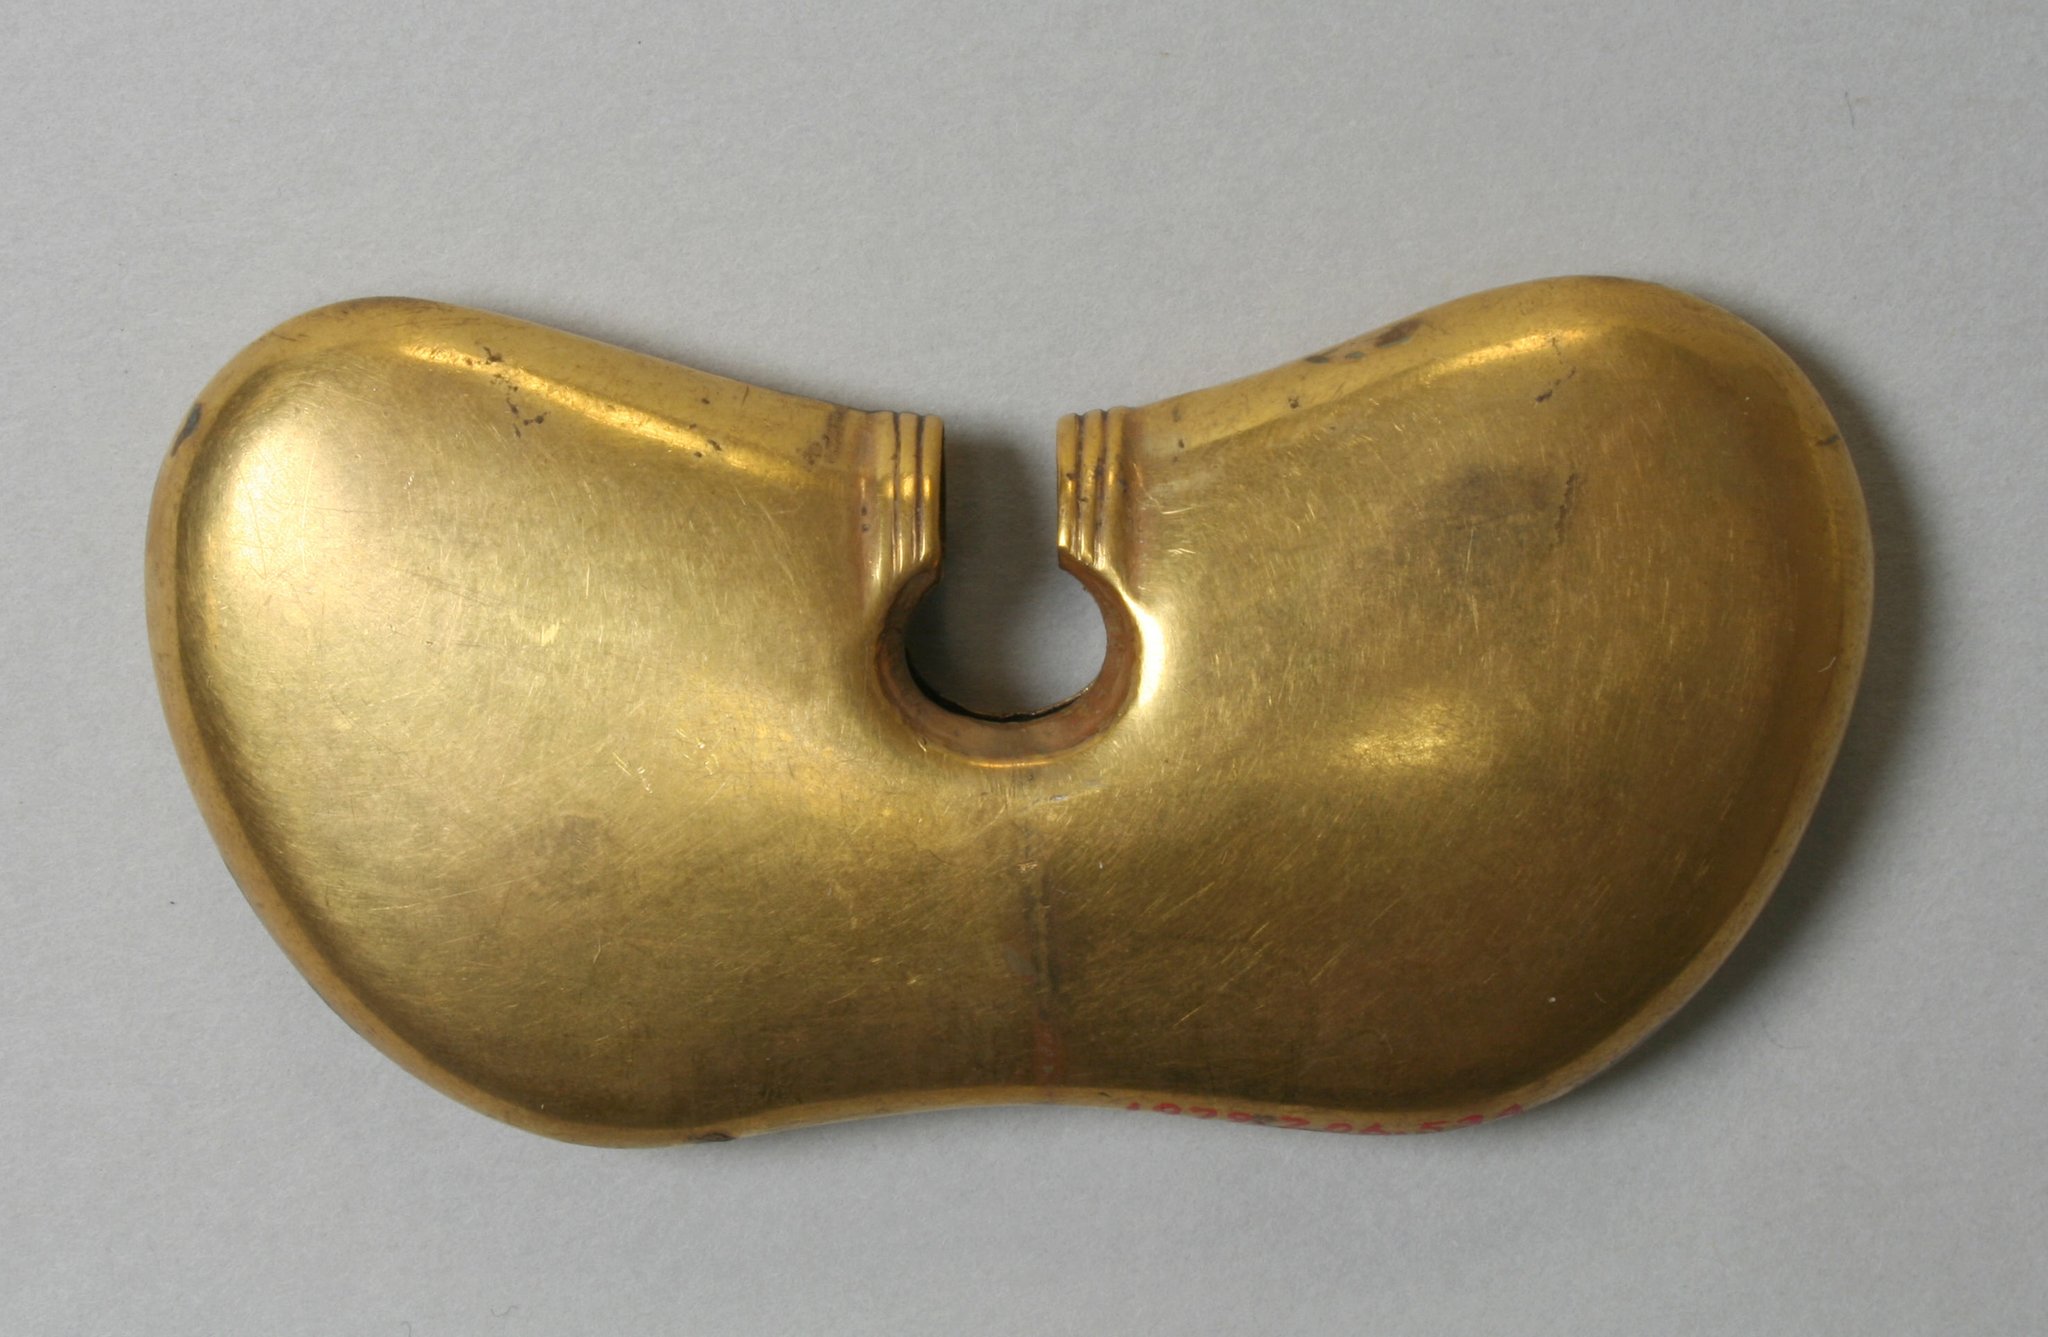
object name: ornament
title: Nose Ornament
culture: early quimbaya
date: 300 BCE-700 CE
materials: alloy, gold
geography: colombia